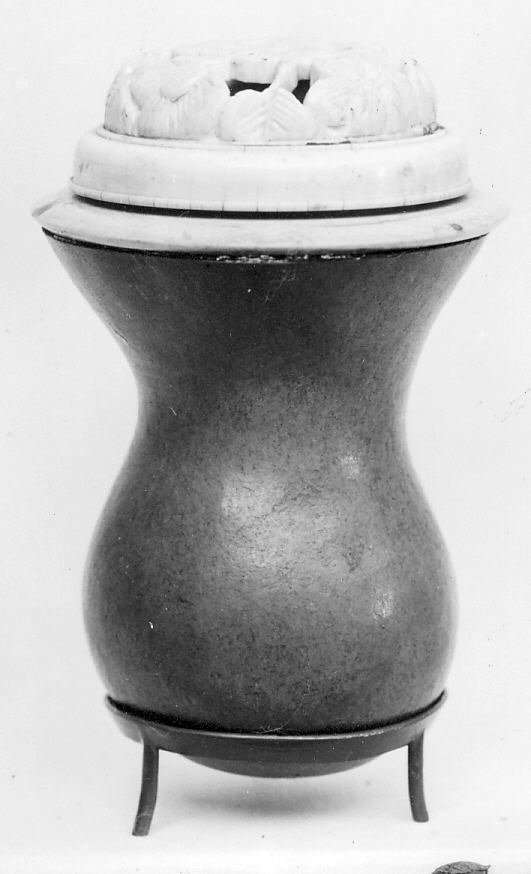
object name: cricket cage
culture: chinese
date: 1701-1900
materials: ivory